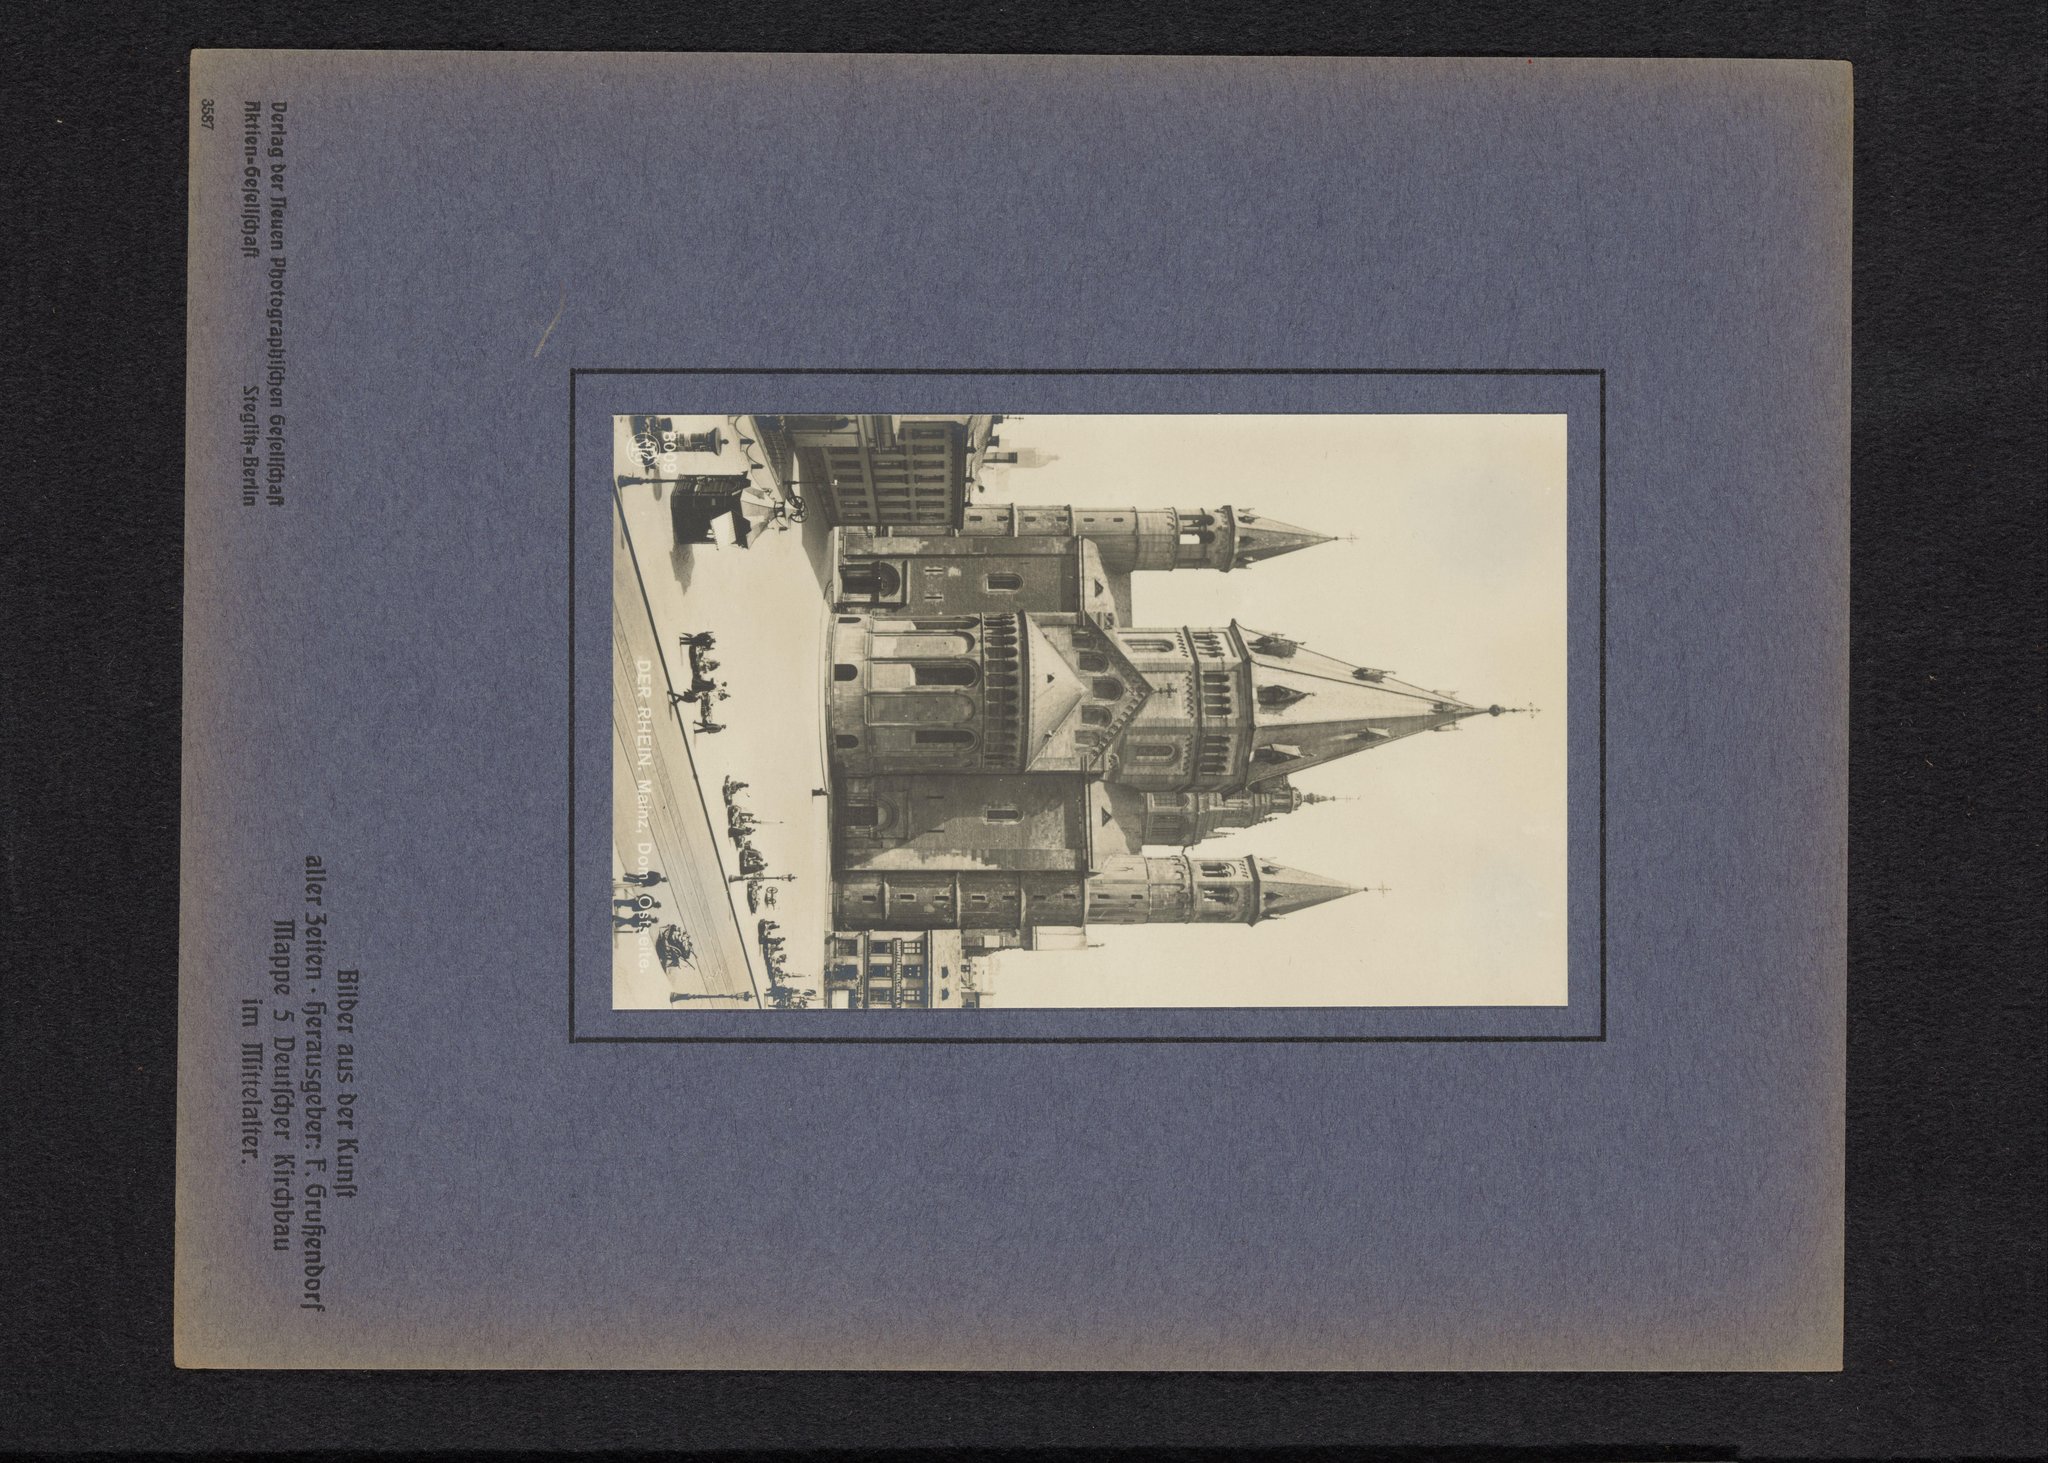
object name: photograph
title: Gezicht op de dom van Mainz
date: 1900-1911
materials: cardboard, photographic support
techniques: gelatin silver print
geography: mainz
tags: church (exterior), parts of church exterior and annexes: tower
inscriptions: number: ‘8009’, number: ‘3587’